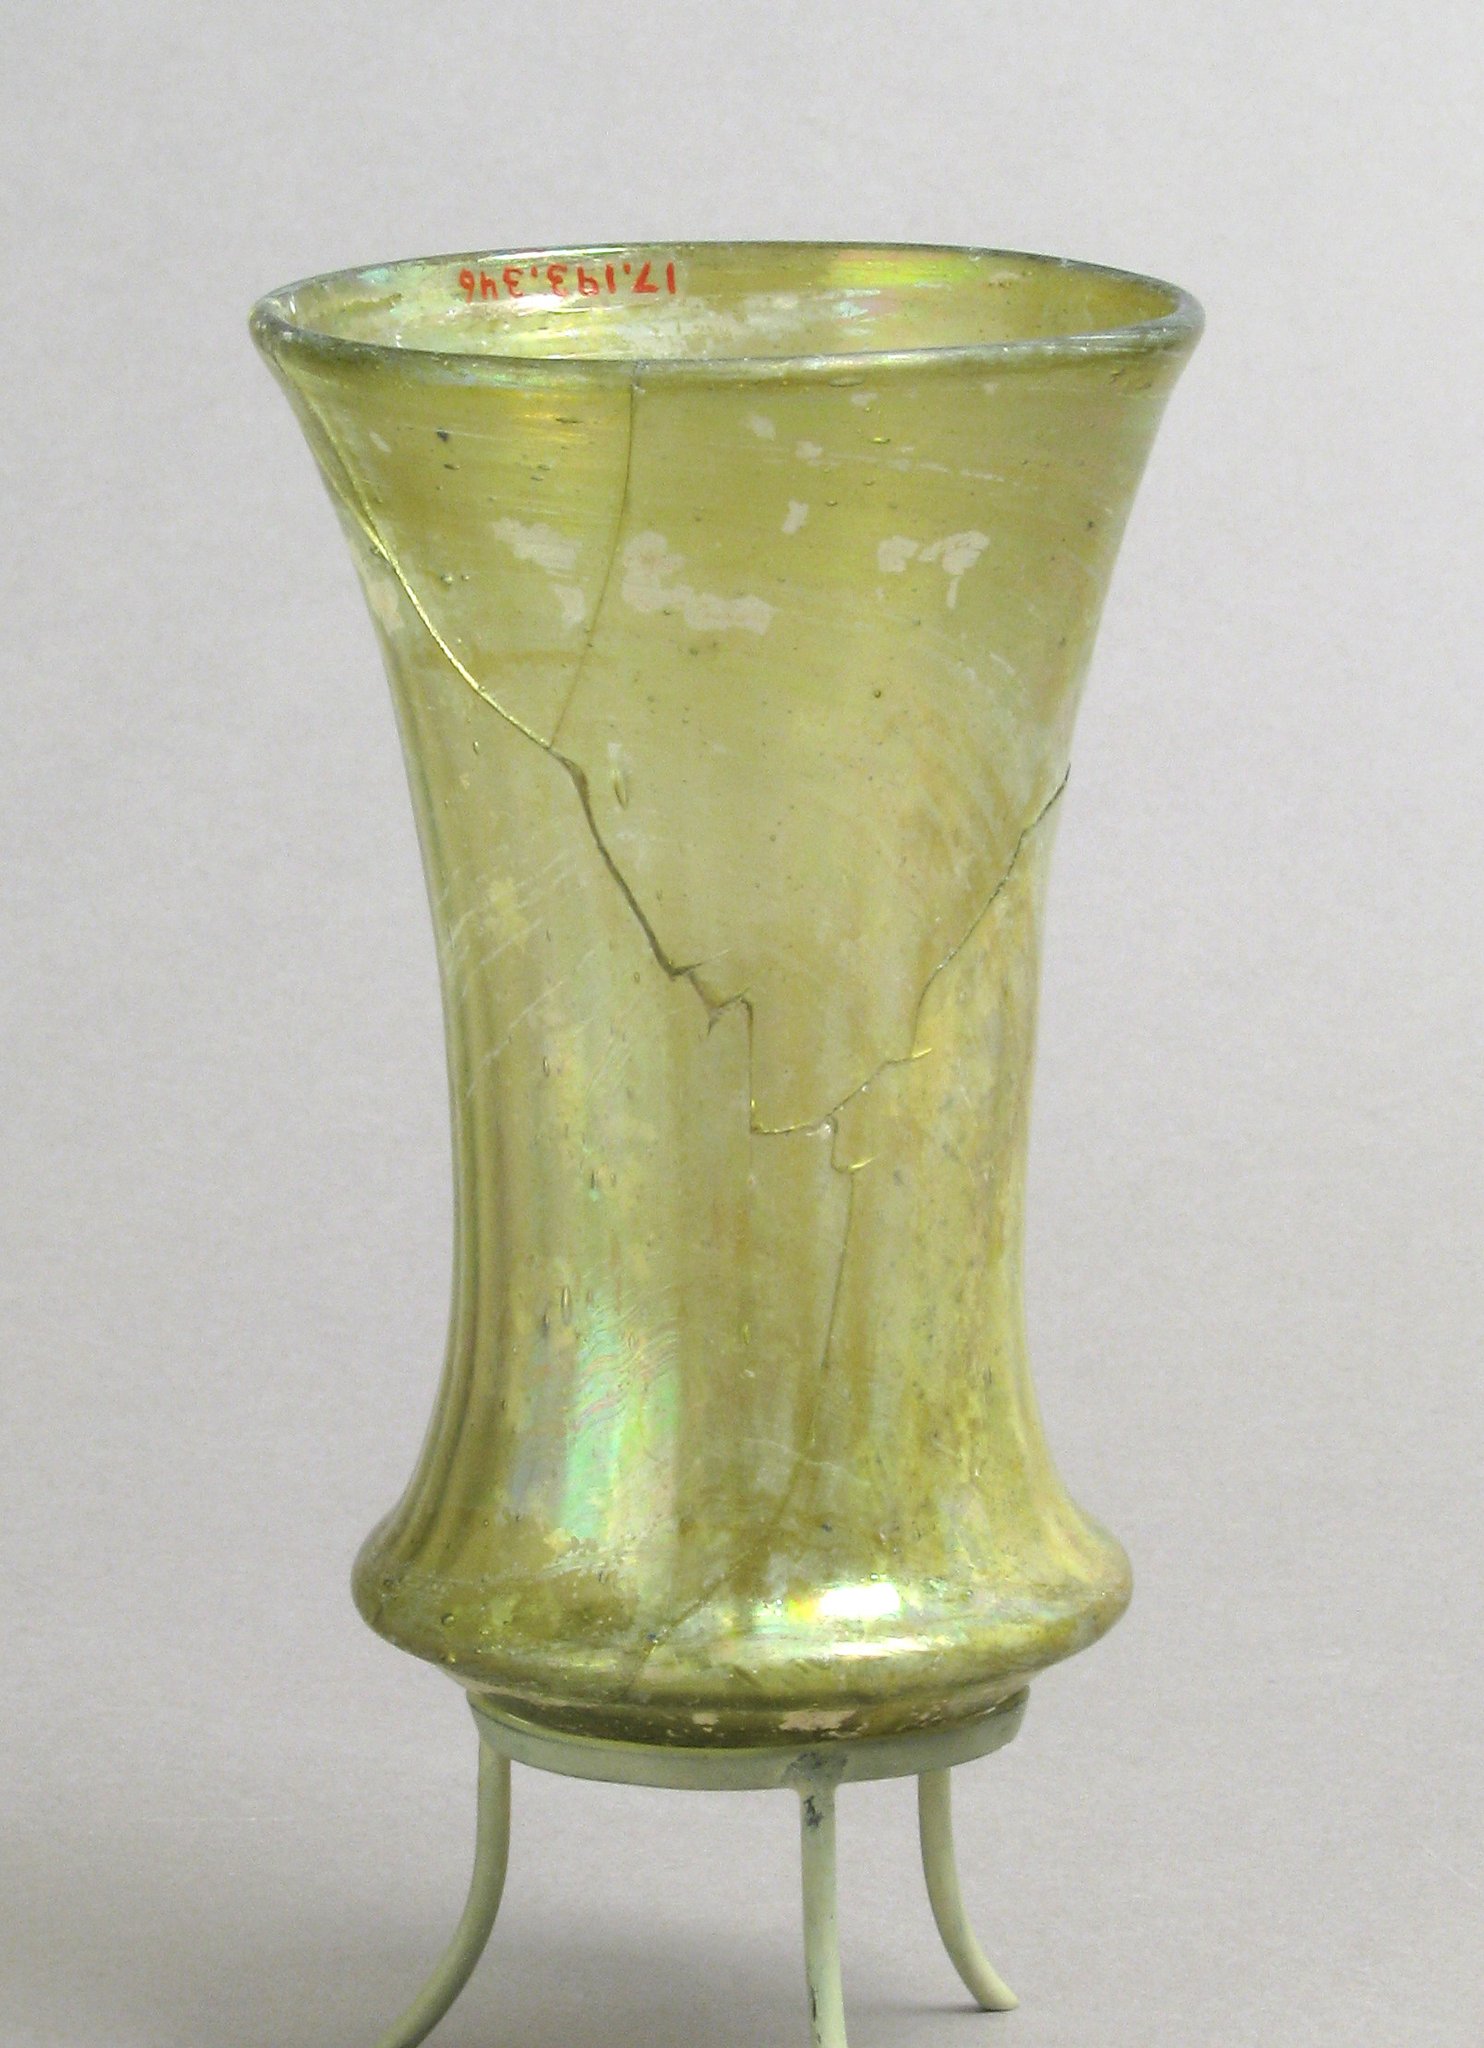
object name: beaker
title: Beaker, Bell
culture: frankish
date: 501-700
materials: glass